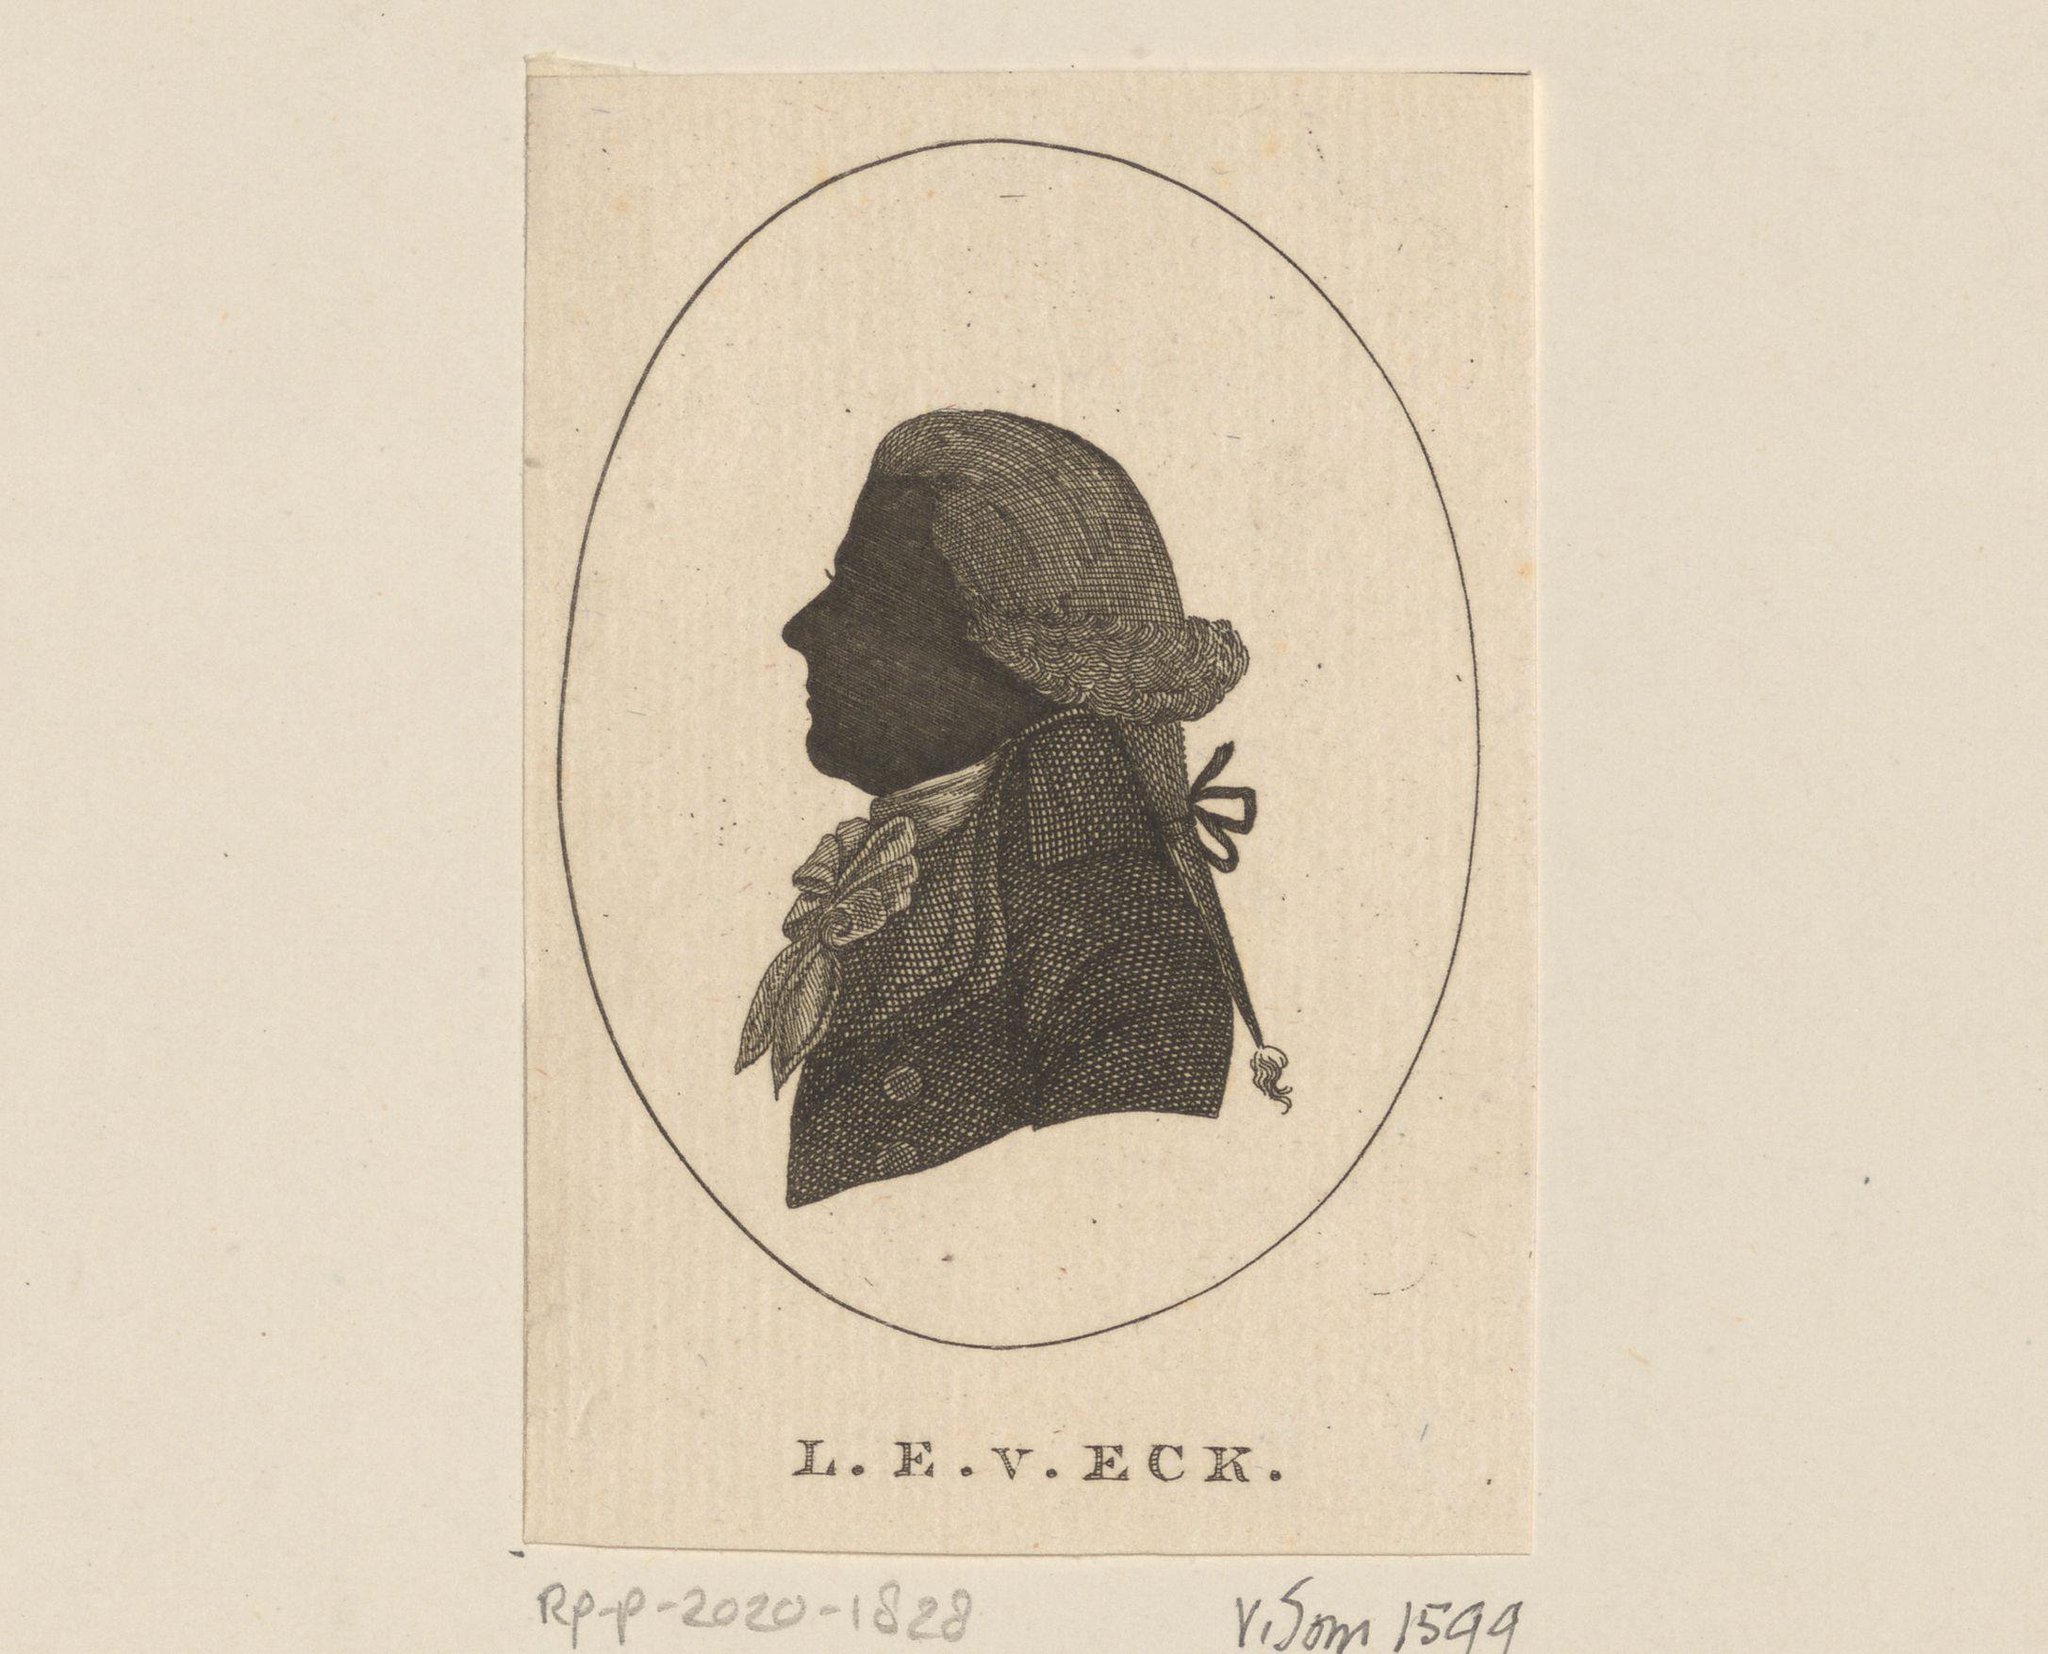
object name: print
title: Silhouetportret van Lambert Engelbert van Eck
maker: Anonymous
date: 1790-1850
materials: paper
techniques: etching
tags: historical persons, politician, e.g. party leader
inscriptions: inscription: ‘R.L.’